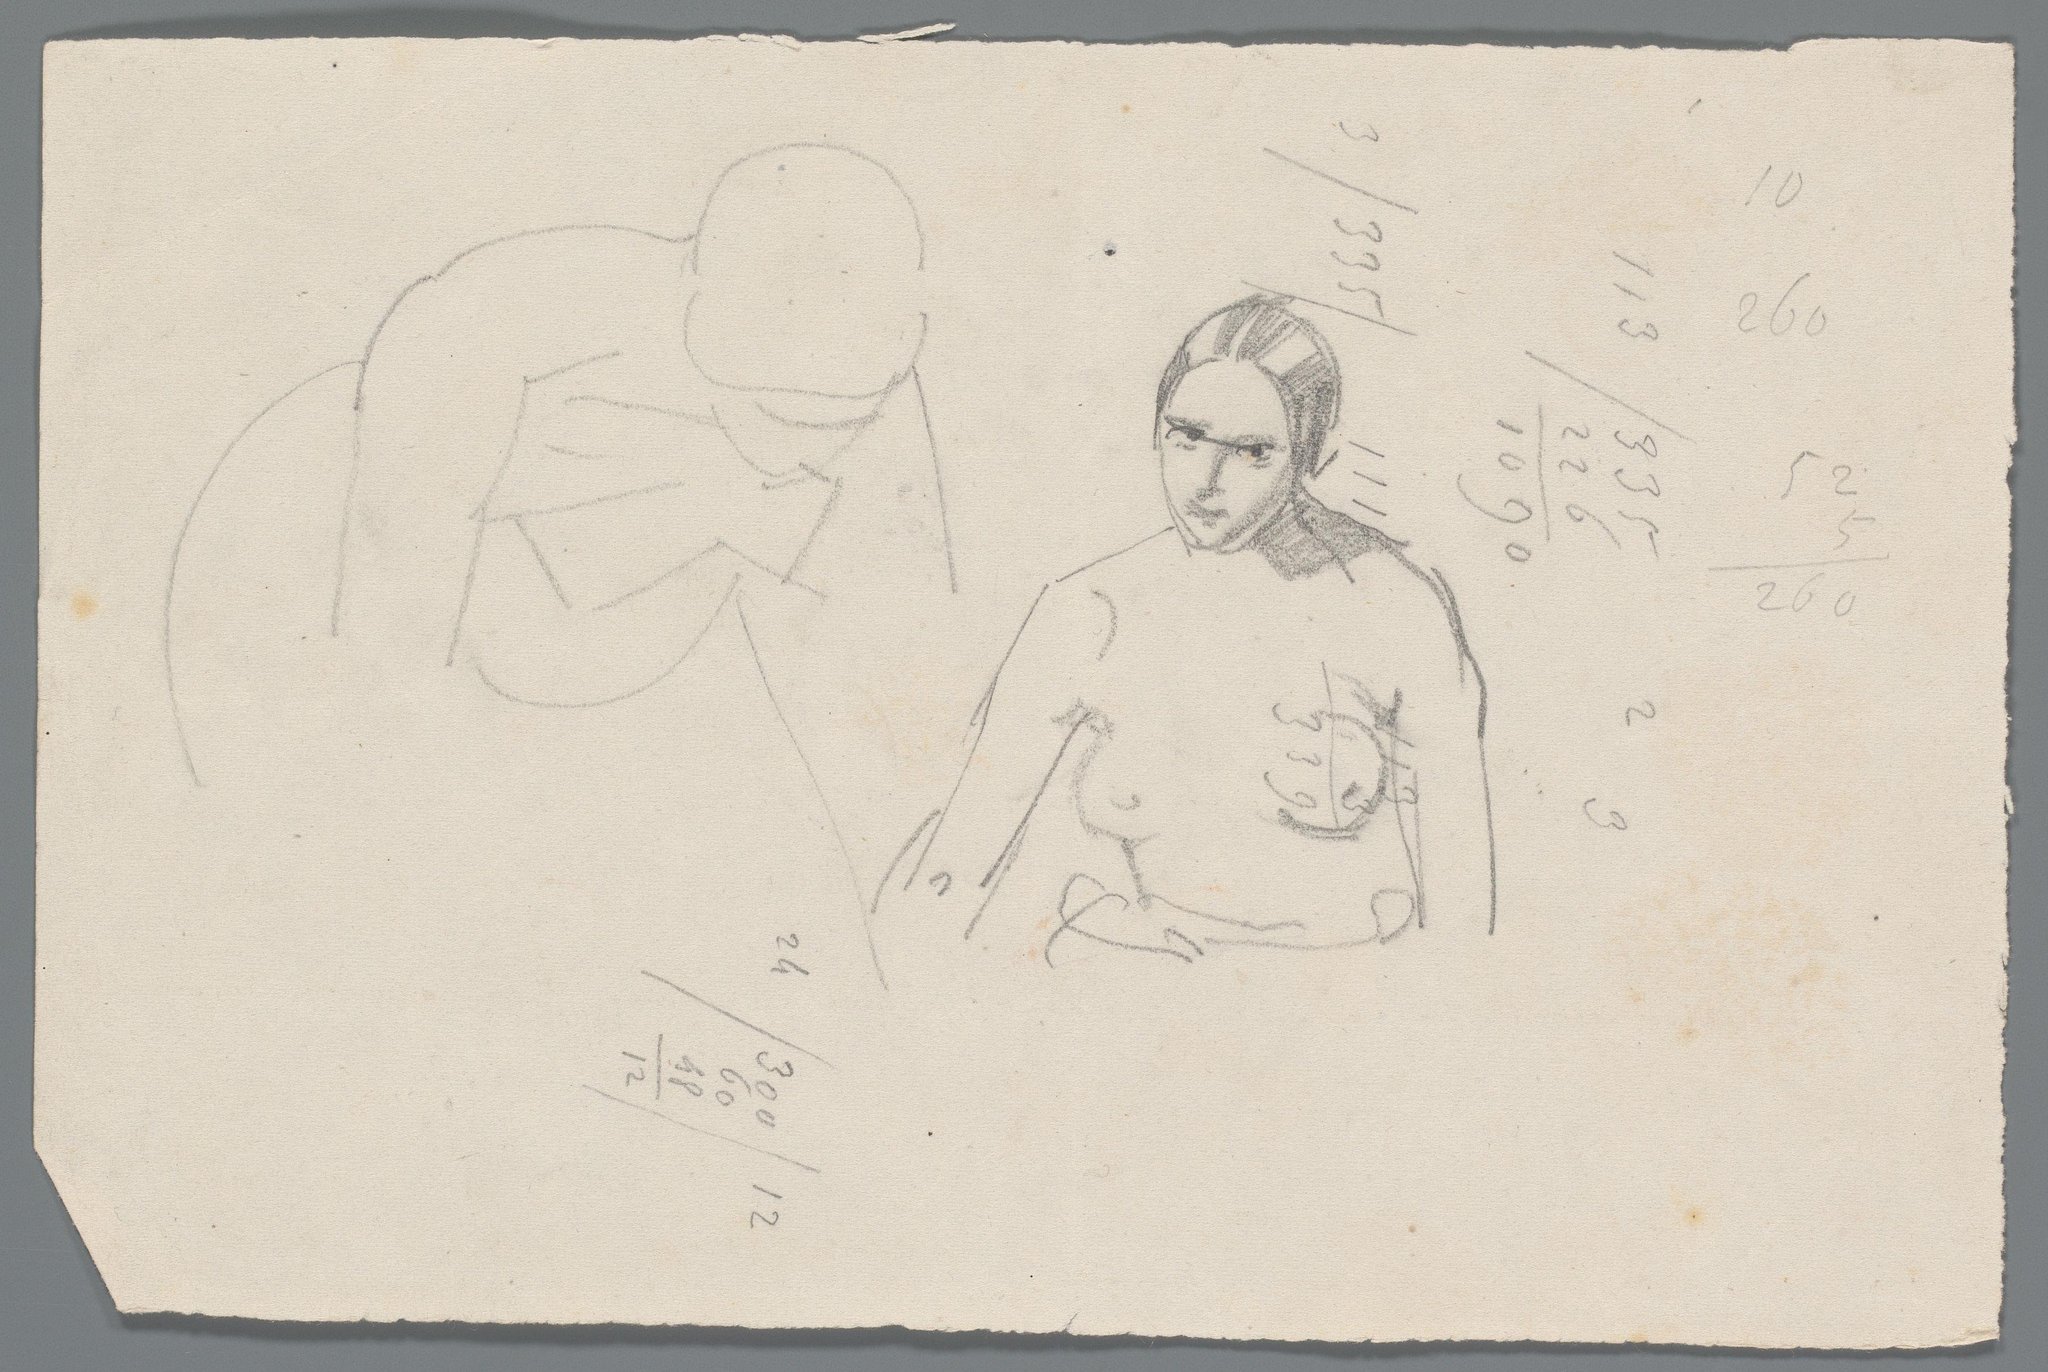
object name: drawing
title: Studies van een vrouw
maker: jacobus everhardus josephus van den berg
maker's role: draughtsman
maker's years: 1802-1861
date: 1812-1861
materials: paper, pencil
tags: the (nude) human figure; 'corpo humano' (ripa) - aa - female human figure